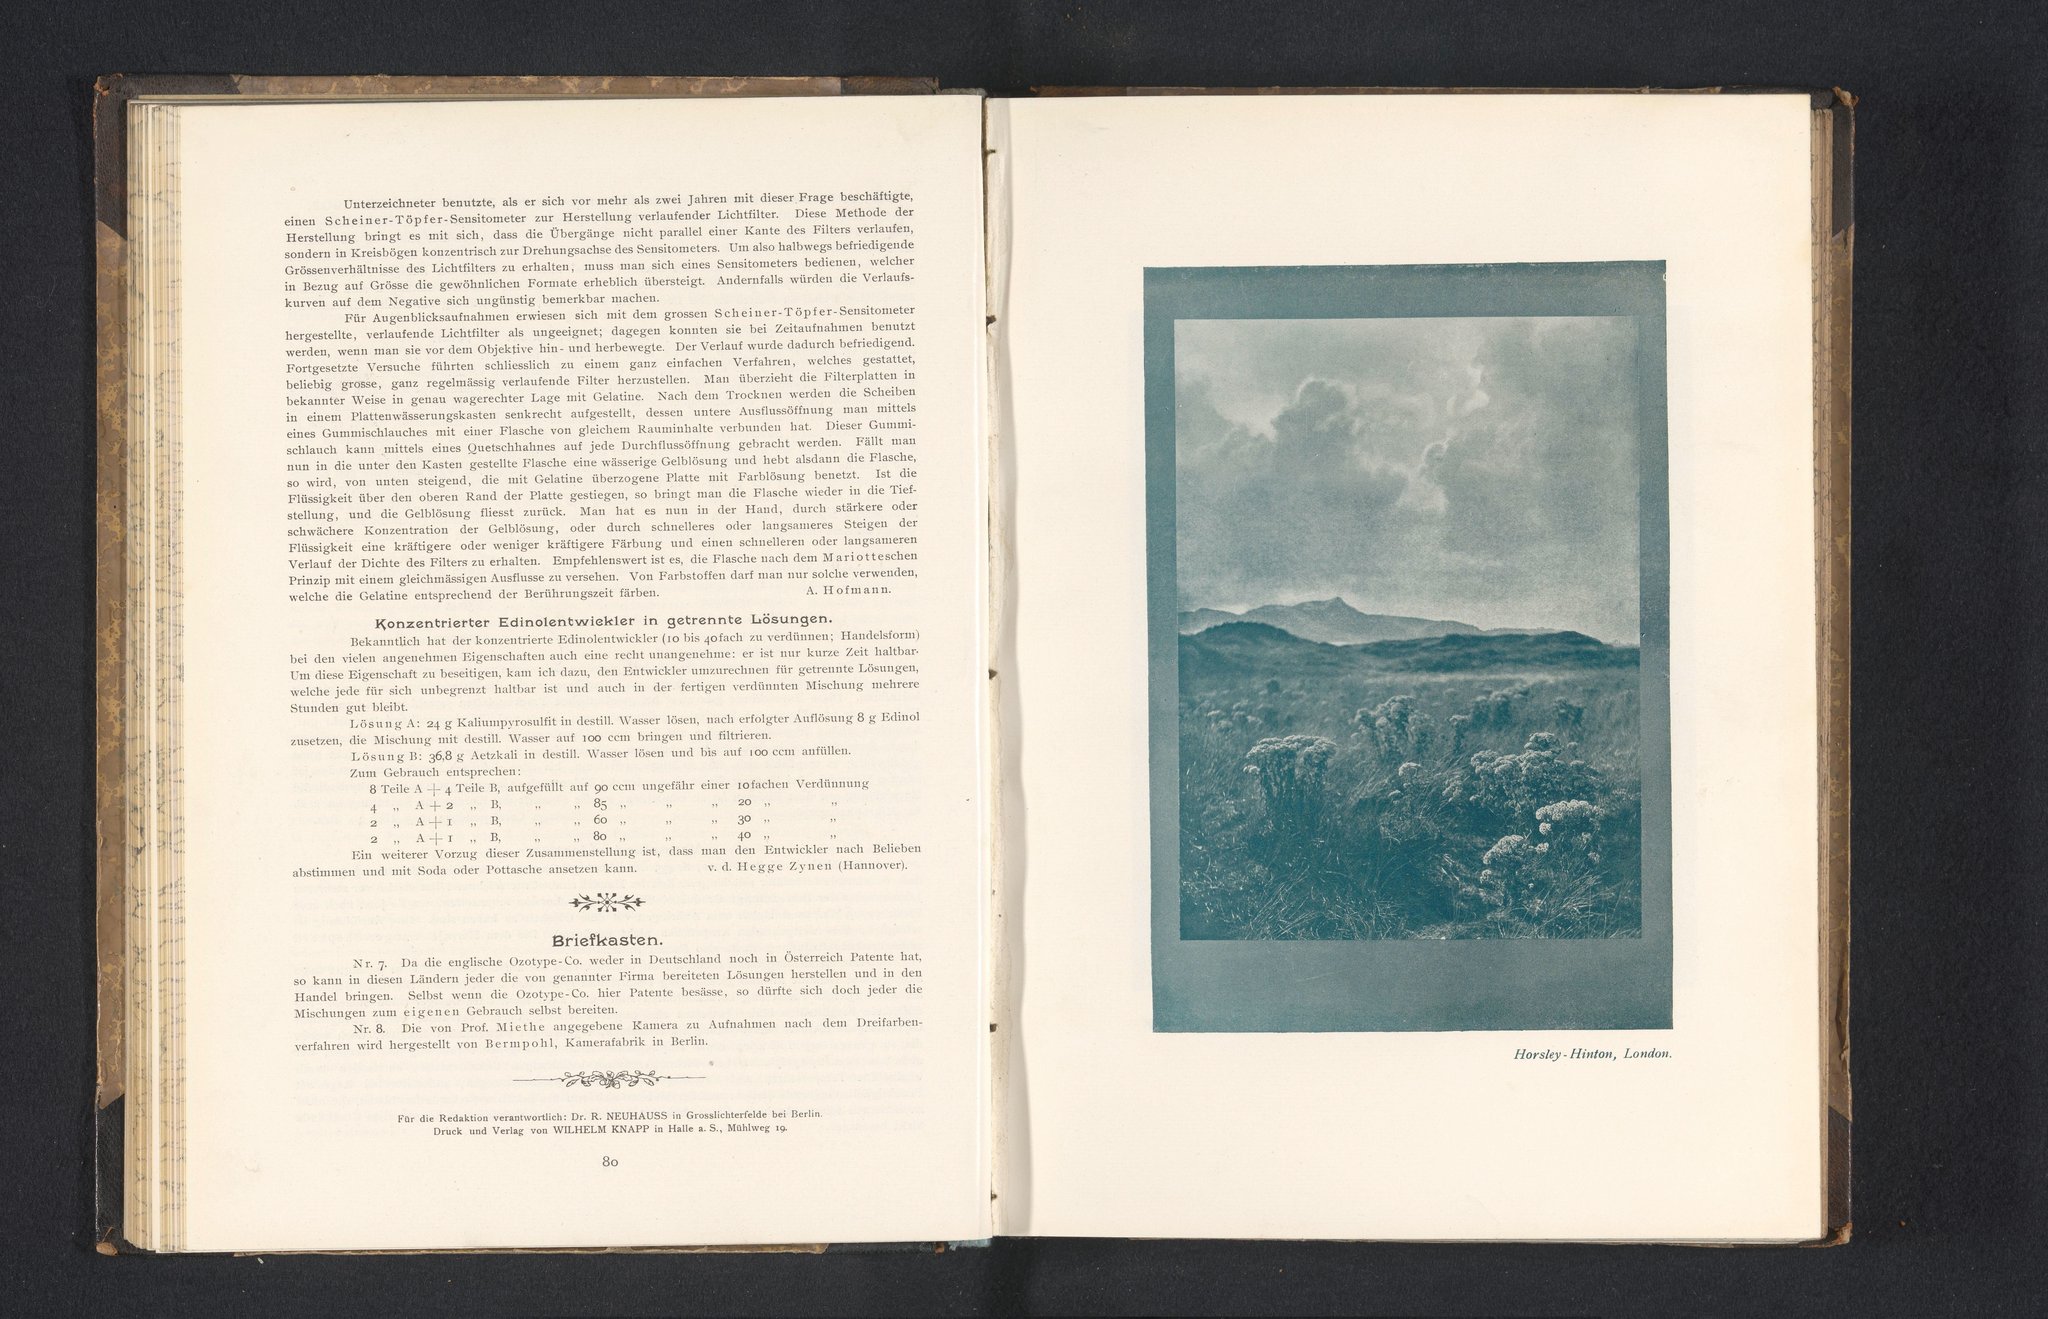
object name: photomechanical print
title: Landschap, met bergen op de achtergrond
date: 1898-1903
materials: paper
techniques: autotype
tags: landscapes, mountains